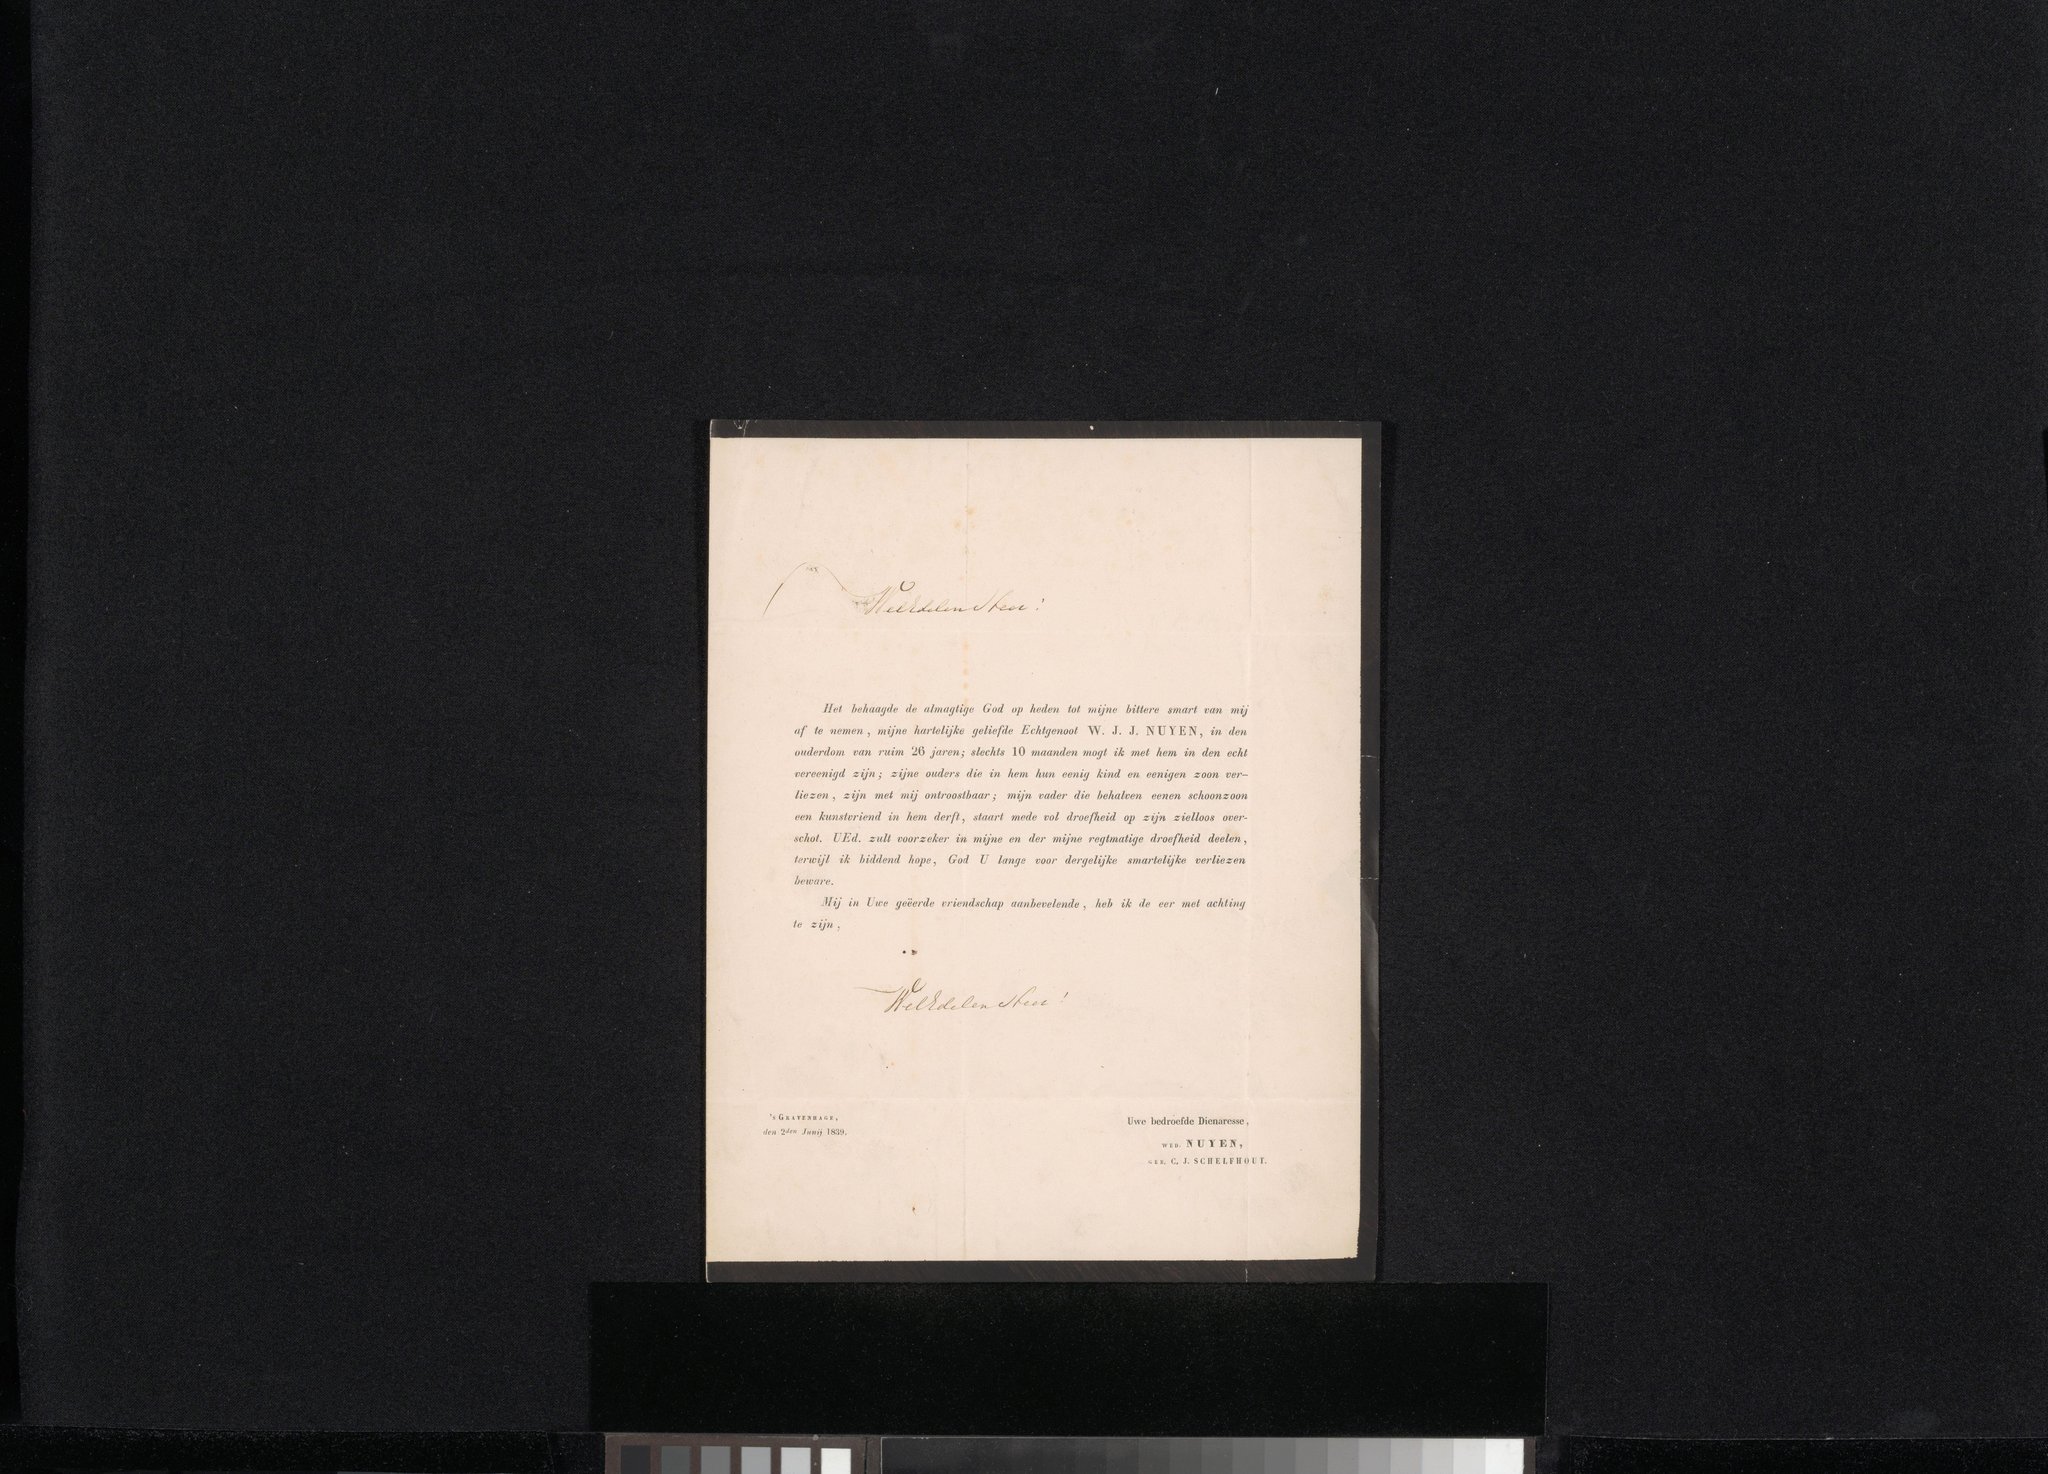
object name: overlijdensbericht, overlijdensadvertentie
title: Overlijdensbericht aan Adriaan van der Willigen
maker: Anonymous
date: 1839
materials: paper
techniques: printing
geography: the hague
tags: the hague, painter, print maker, draughtsman, wijnand nuijen, haarlem, adriaan van der willigen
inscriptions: seal